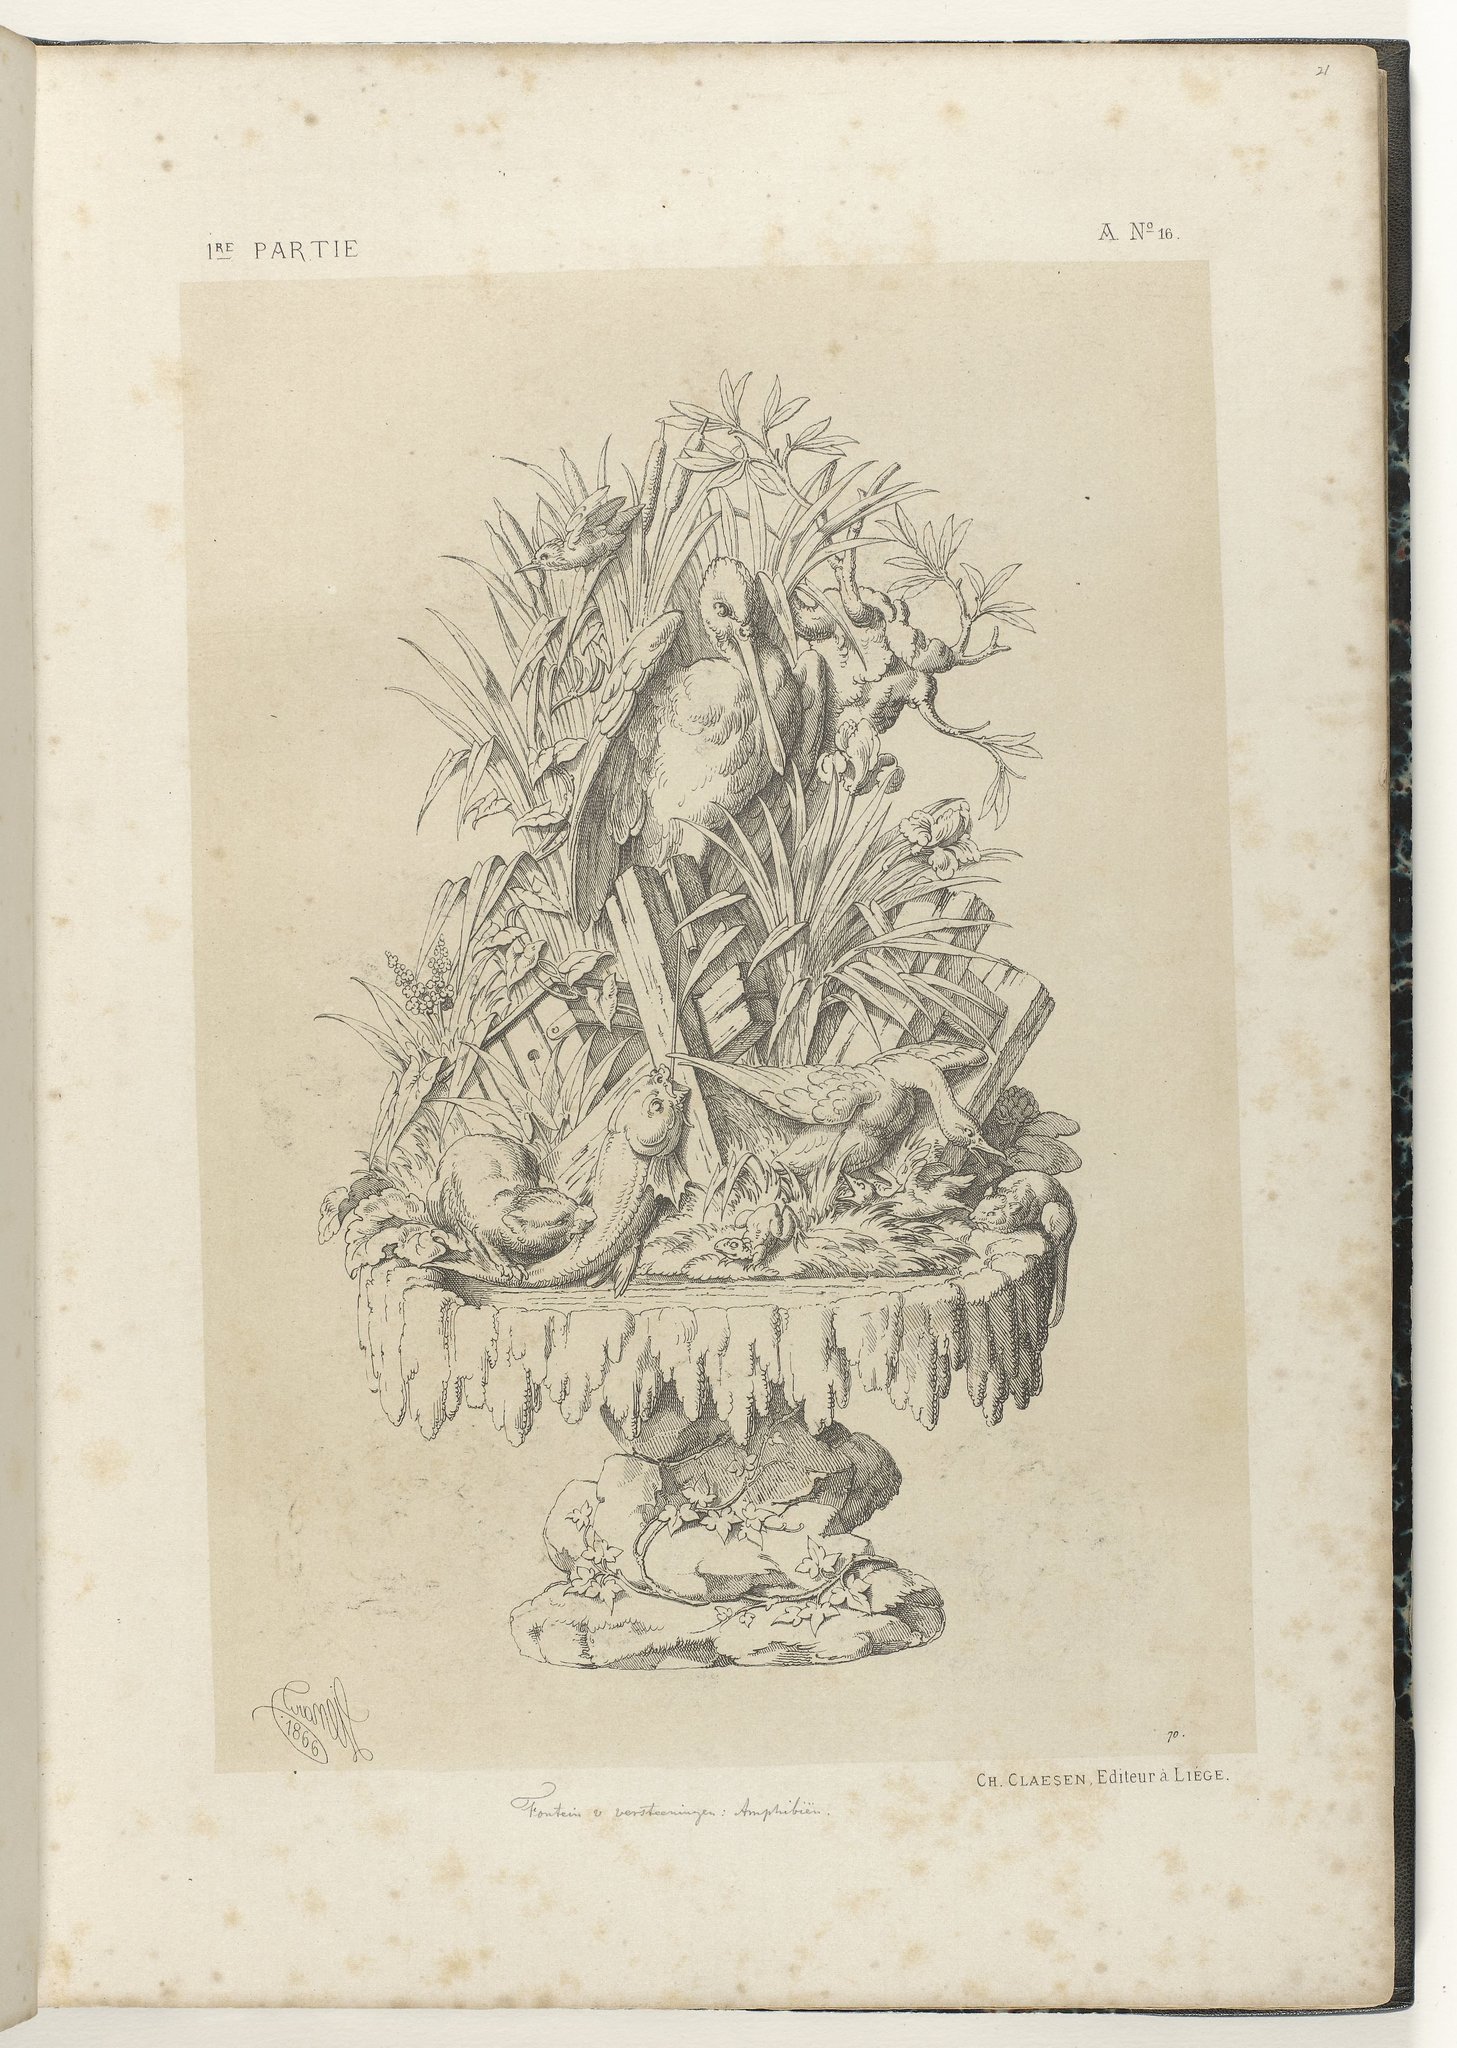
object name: print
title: Vijver met dieren en planten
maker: michel liénard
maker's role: print maker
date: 1866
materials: paper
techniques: tone lithography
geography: liège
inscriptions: annotation: ‘Fontein v versteeningen : Amphibiën.’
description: Fontein in de vorm van een vijver op een rots, midden boven staat een lepelaar. Linksboven: 1re partie, rechtsboven: A. N° 16., rechtsonder: 70.